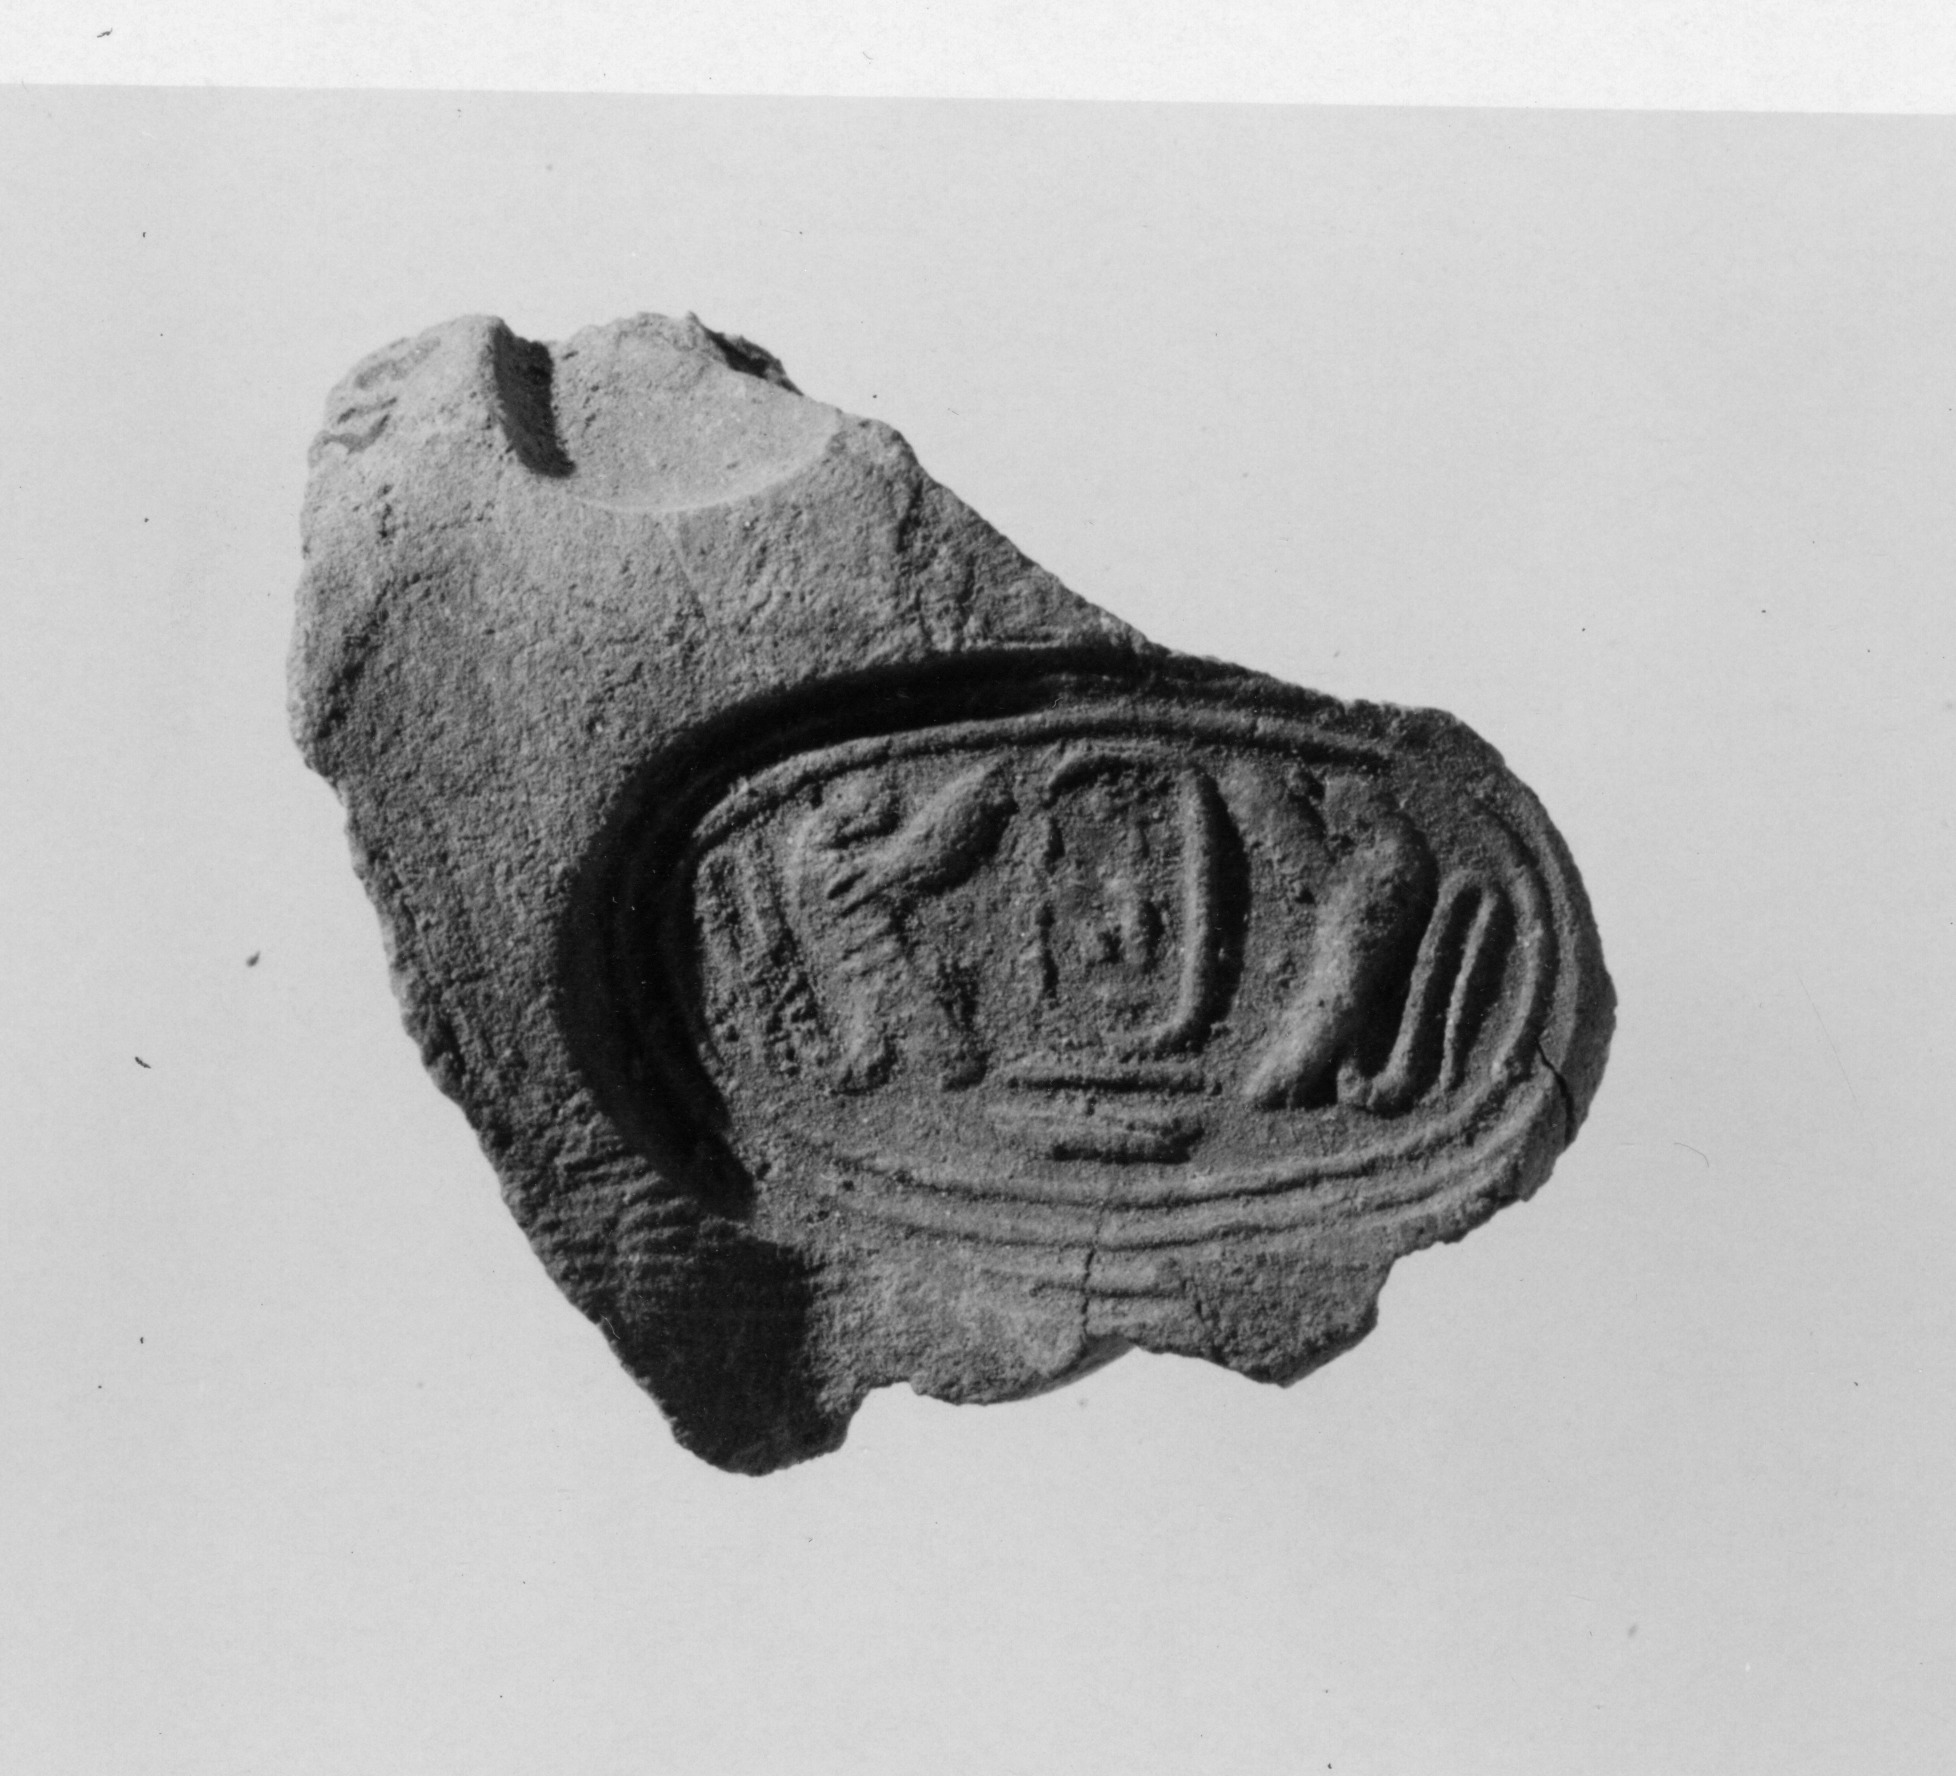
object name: sealing, amenhotep iii, nebmaatre, cobra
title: Document Sealing With Multiple Seal Impressions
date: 1390-1352 BCE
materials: mud